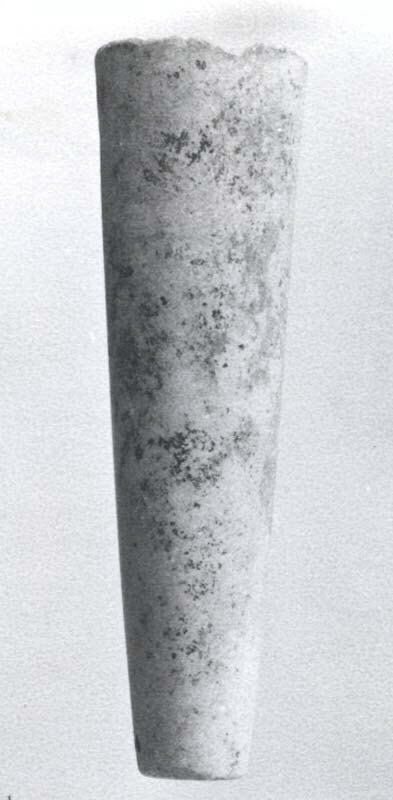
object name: vase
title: Bud vase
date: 2700-2600 BCE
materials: limestone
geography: mesopotamia